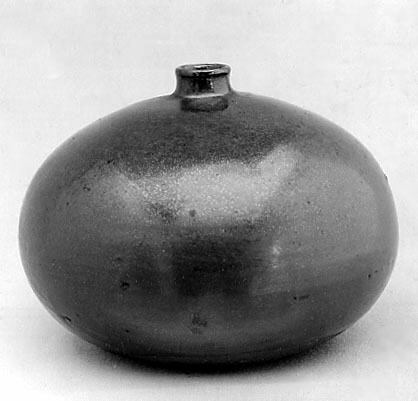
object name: bottle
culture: japanese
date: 1801-1900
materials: clay, glaze